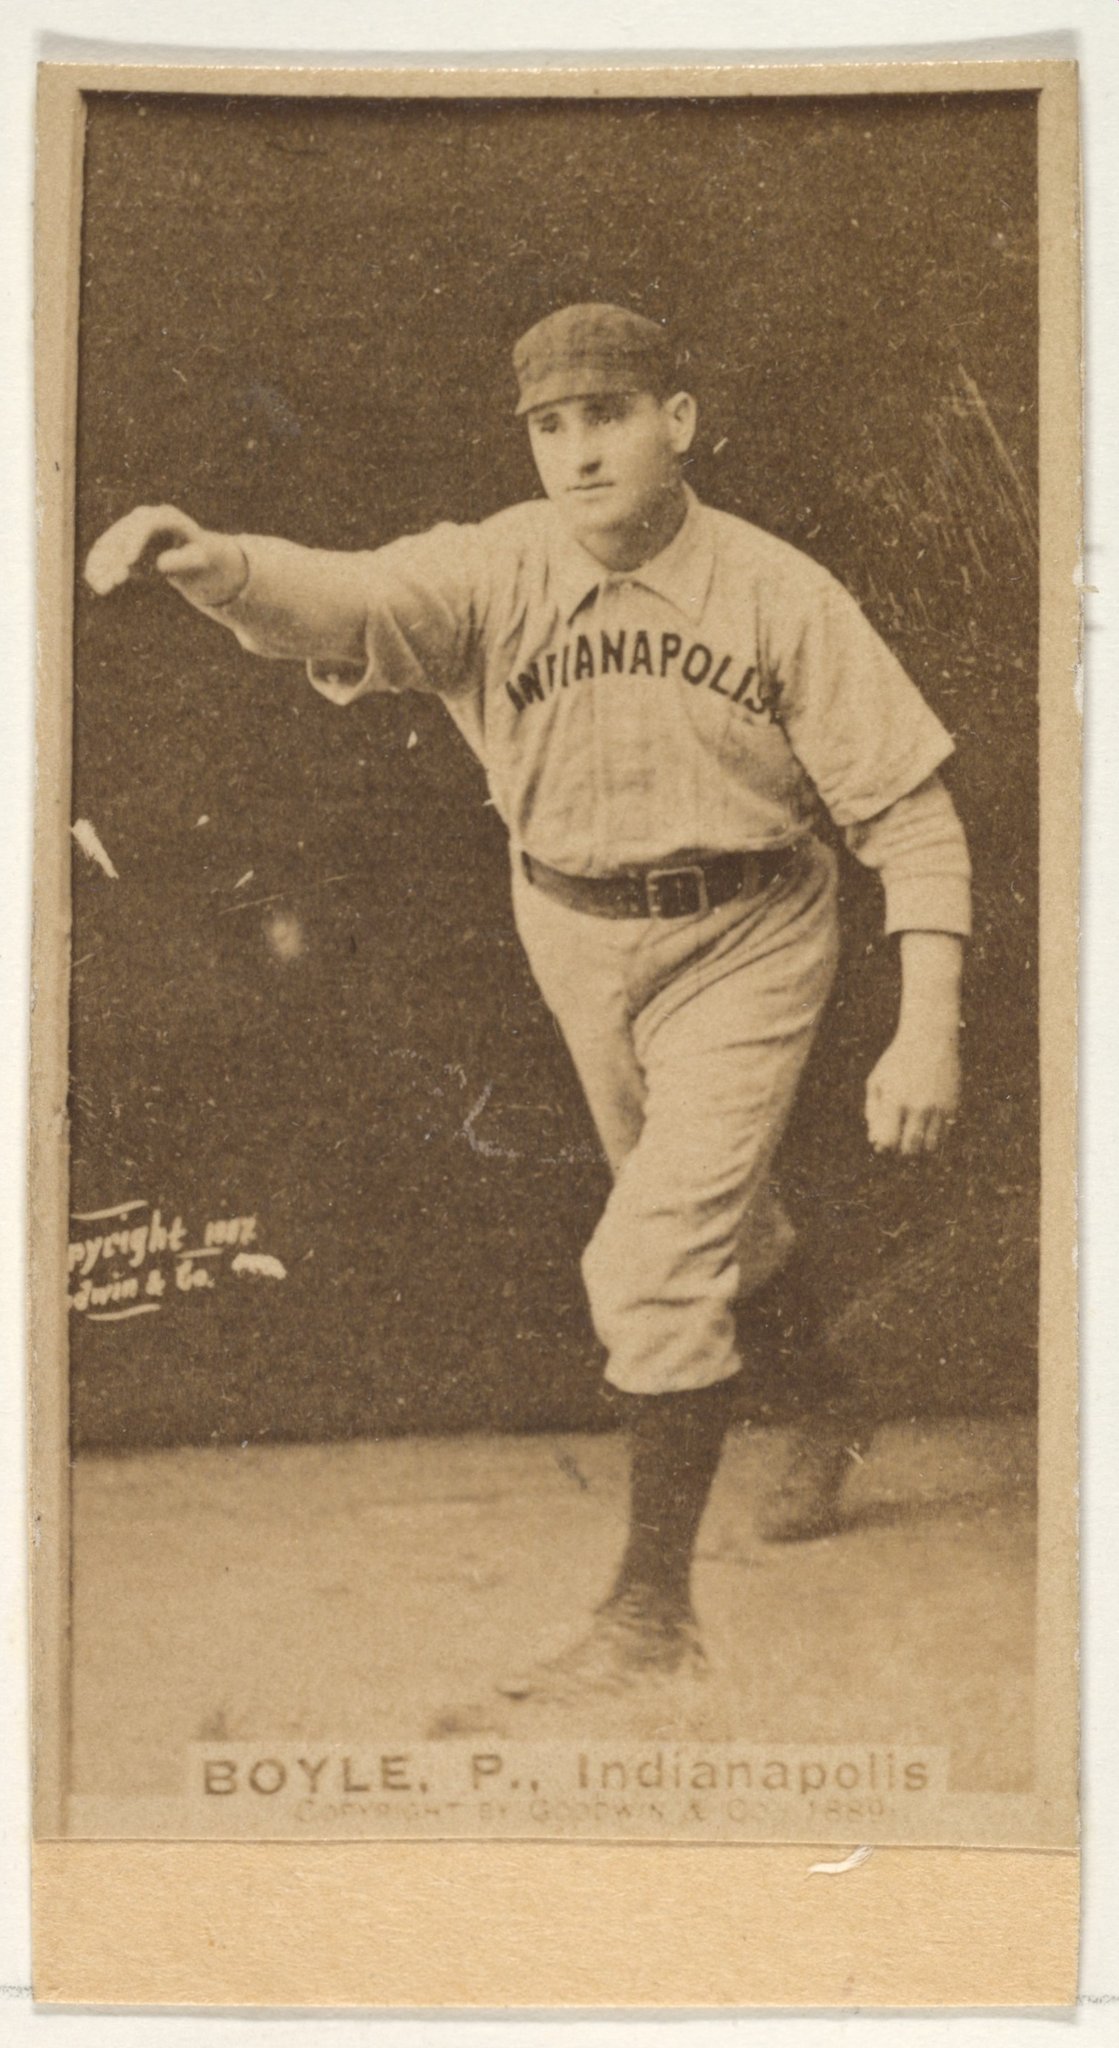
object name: baseball card, photograph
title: Boyle, Pitcher, Indianapolis, from the Old Judge series (N172) for Old Judge Cigarettes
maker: goodwin & company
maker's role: publisher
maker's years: 1850-1950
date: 1887-1890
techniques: albumen silver print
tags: men,portraits,baseball,athletes